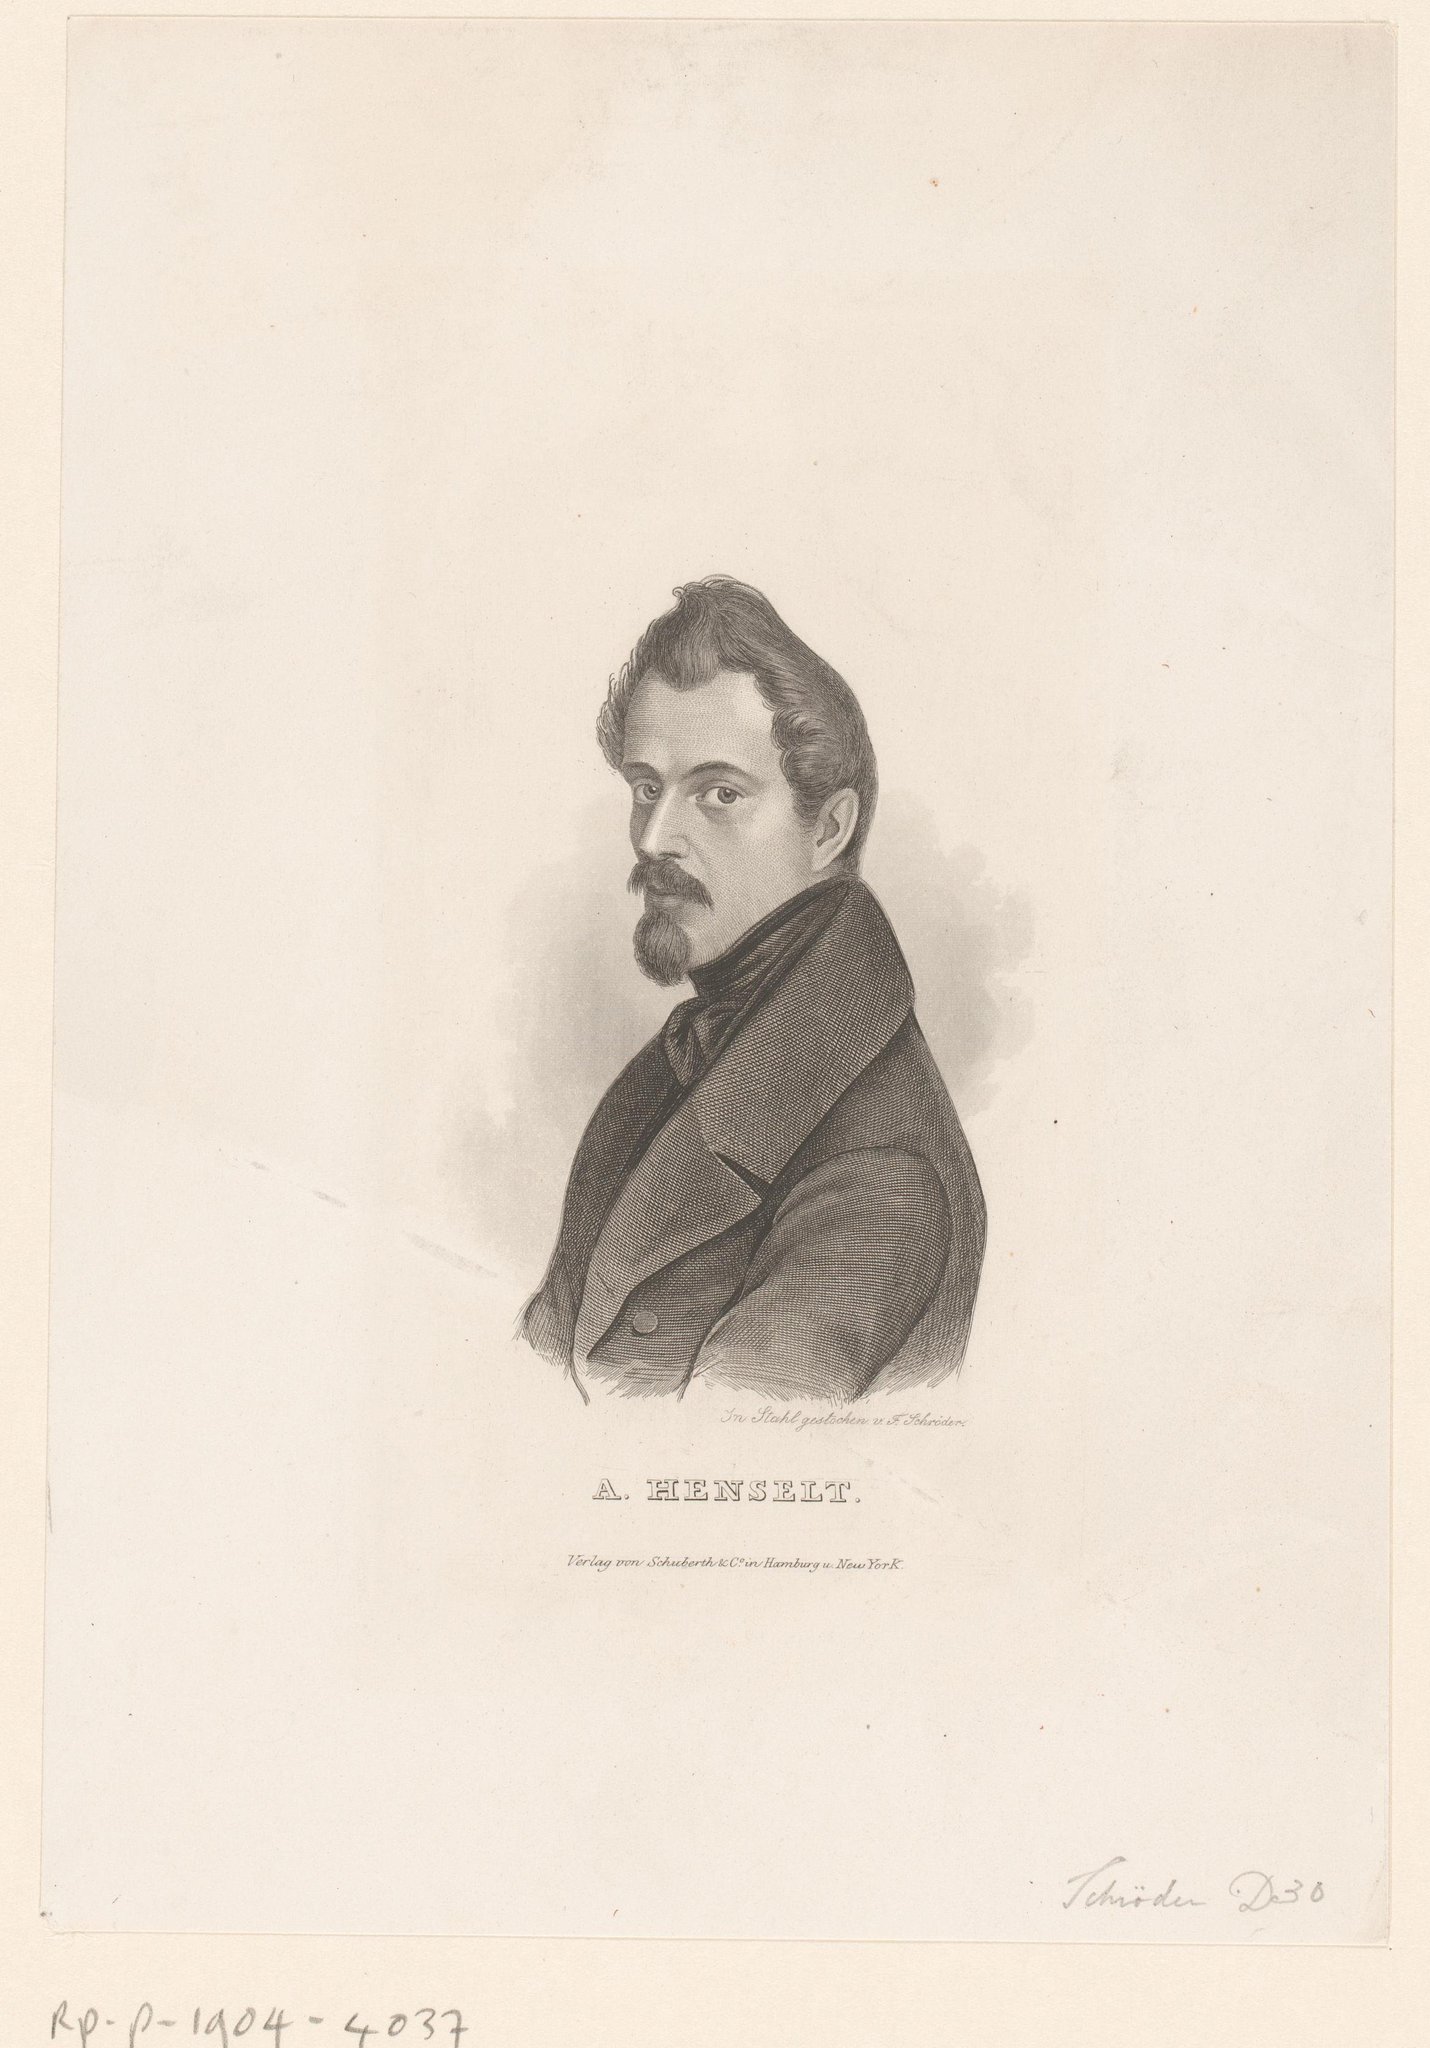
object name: print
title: Portret van Adolph Henselt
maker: friedrich schröder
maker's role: draughtsman, print maker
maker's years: 1768-1839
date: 1824-1839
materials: paper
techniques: engraving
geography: new york city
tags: historical persons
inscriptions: collector's mark: Lugt 2228